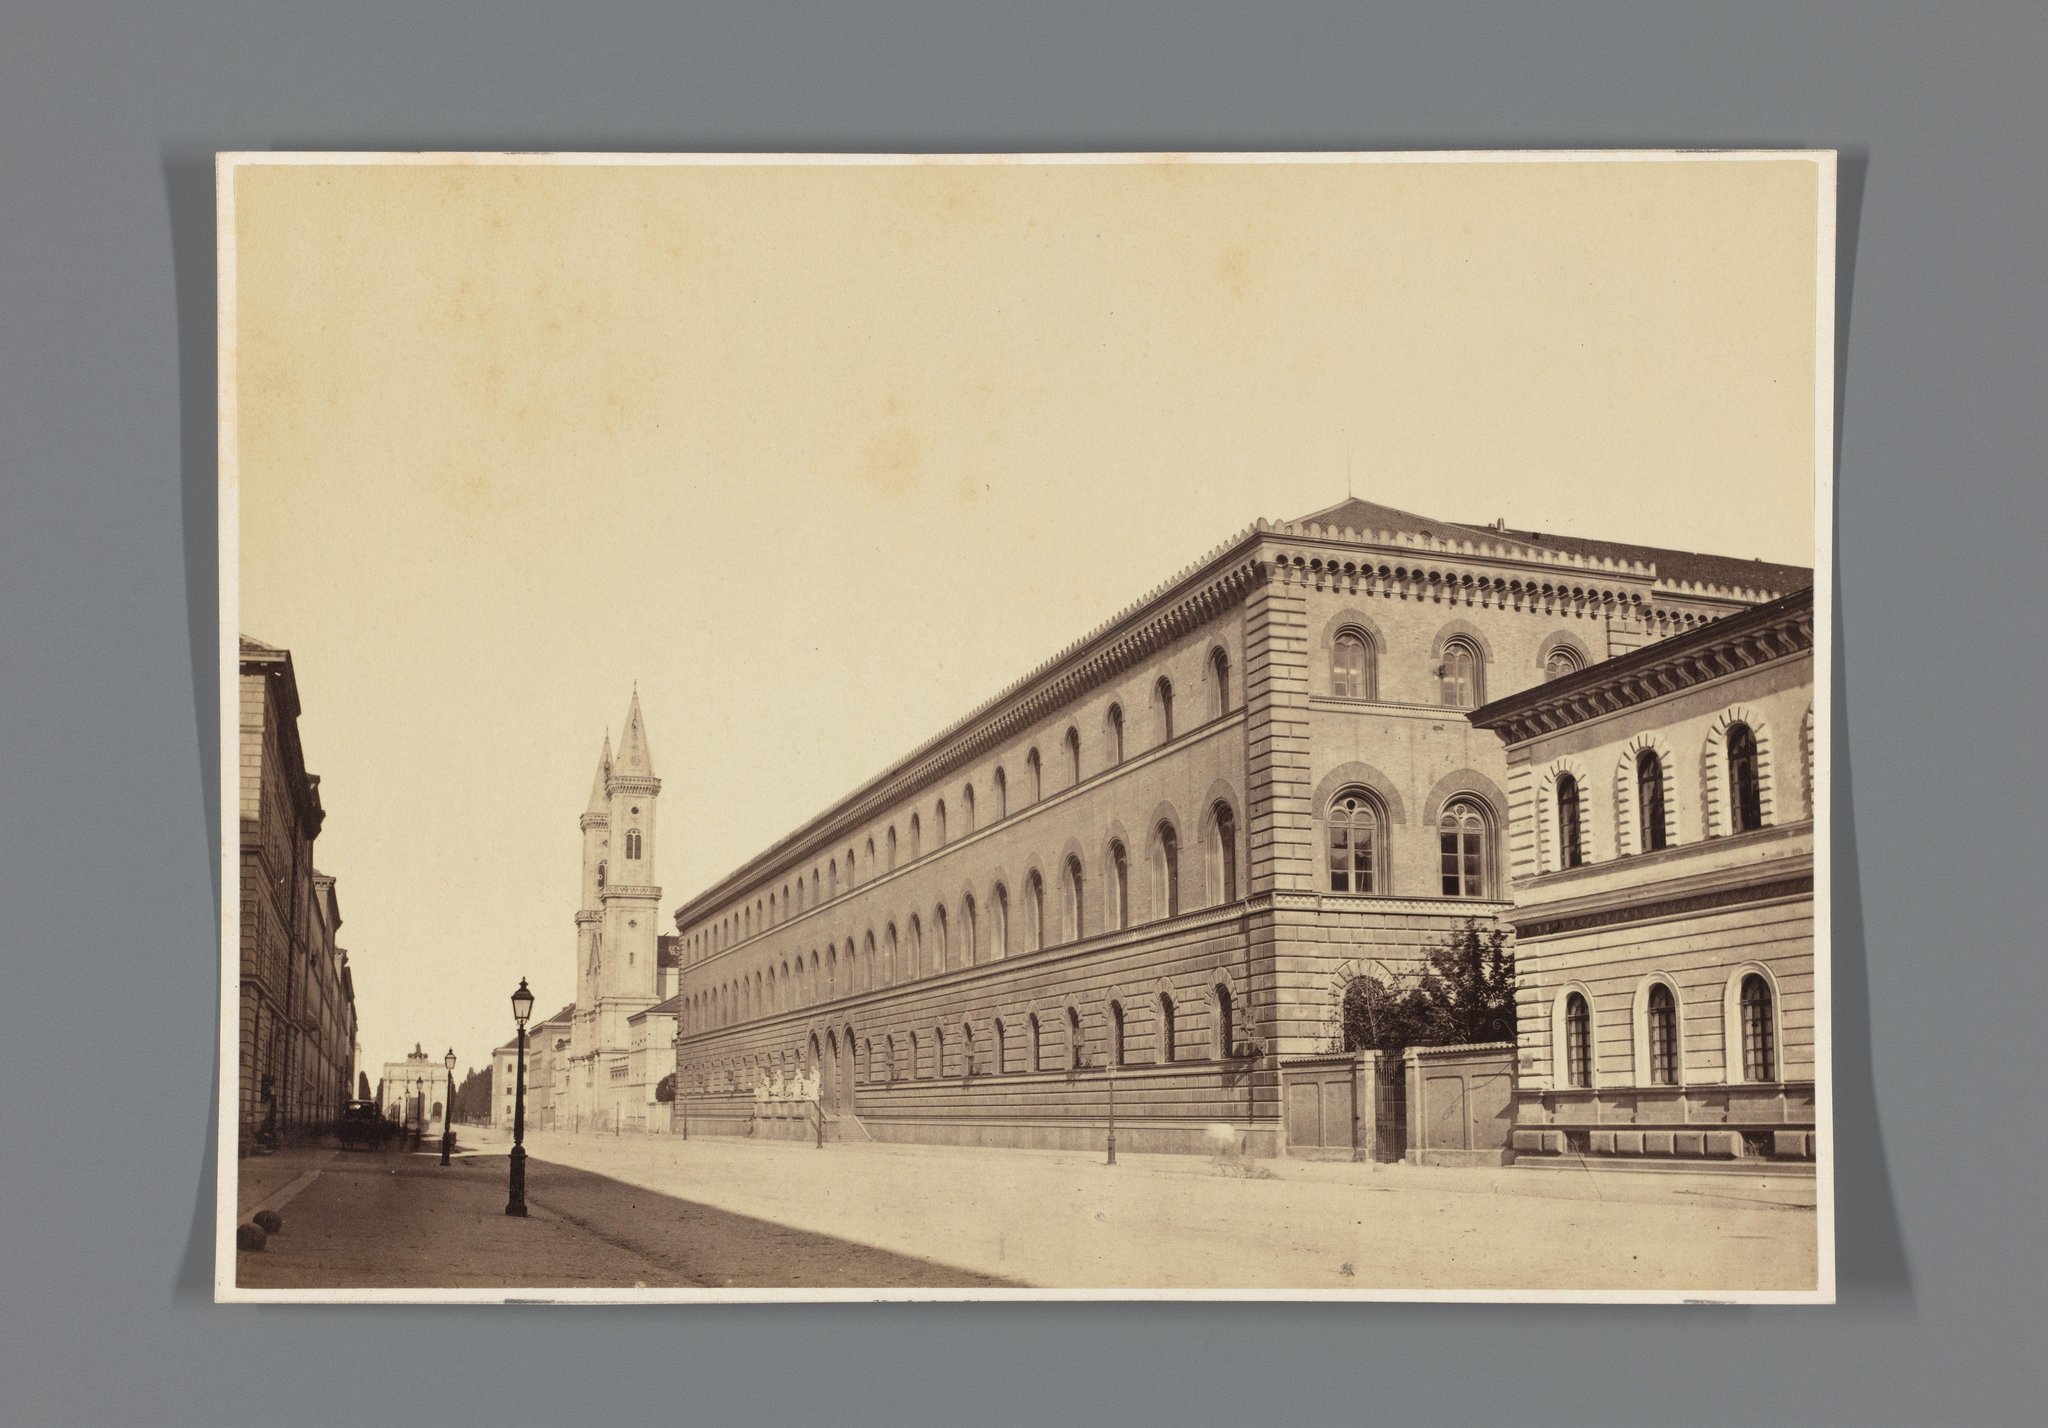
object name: photograph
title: Stadsbibliothek München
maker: Anonymous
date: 1850-1900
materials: cardboard, photographic support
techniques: albumen print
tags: münchen